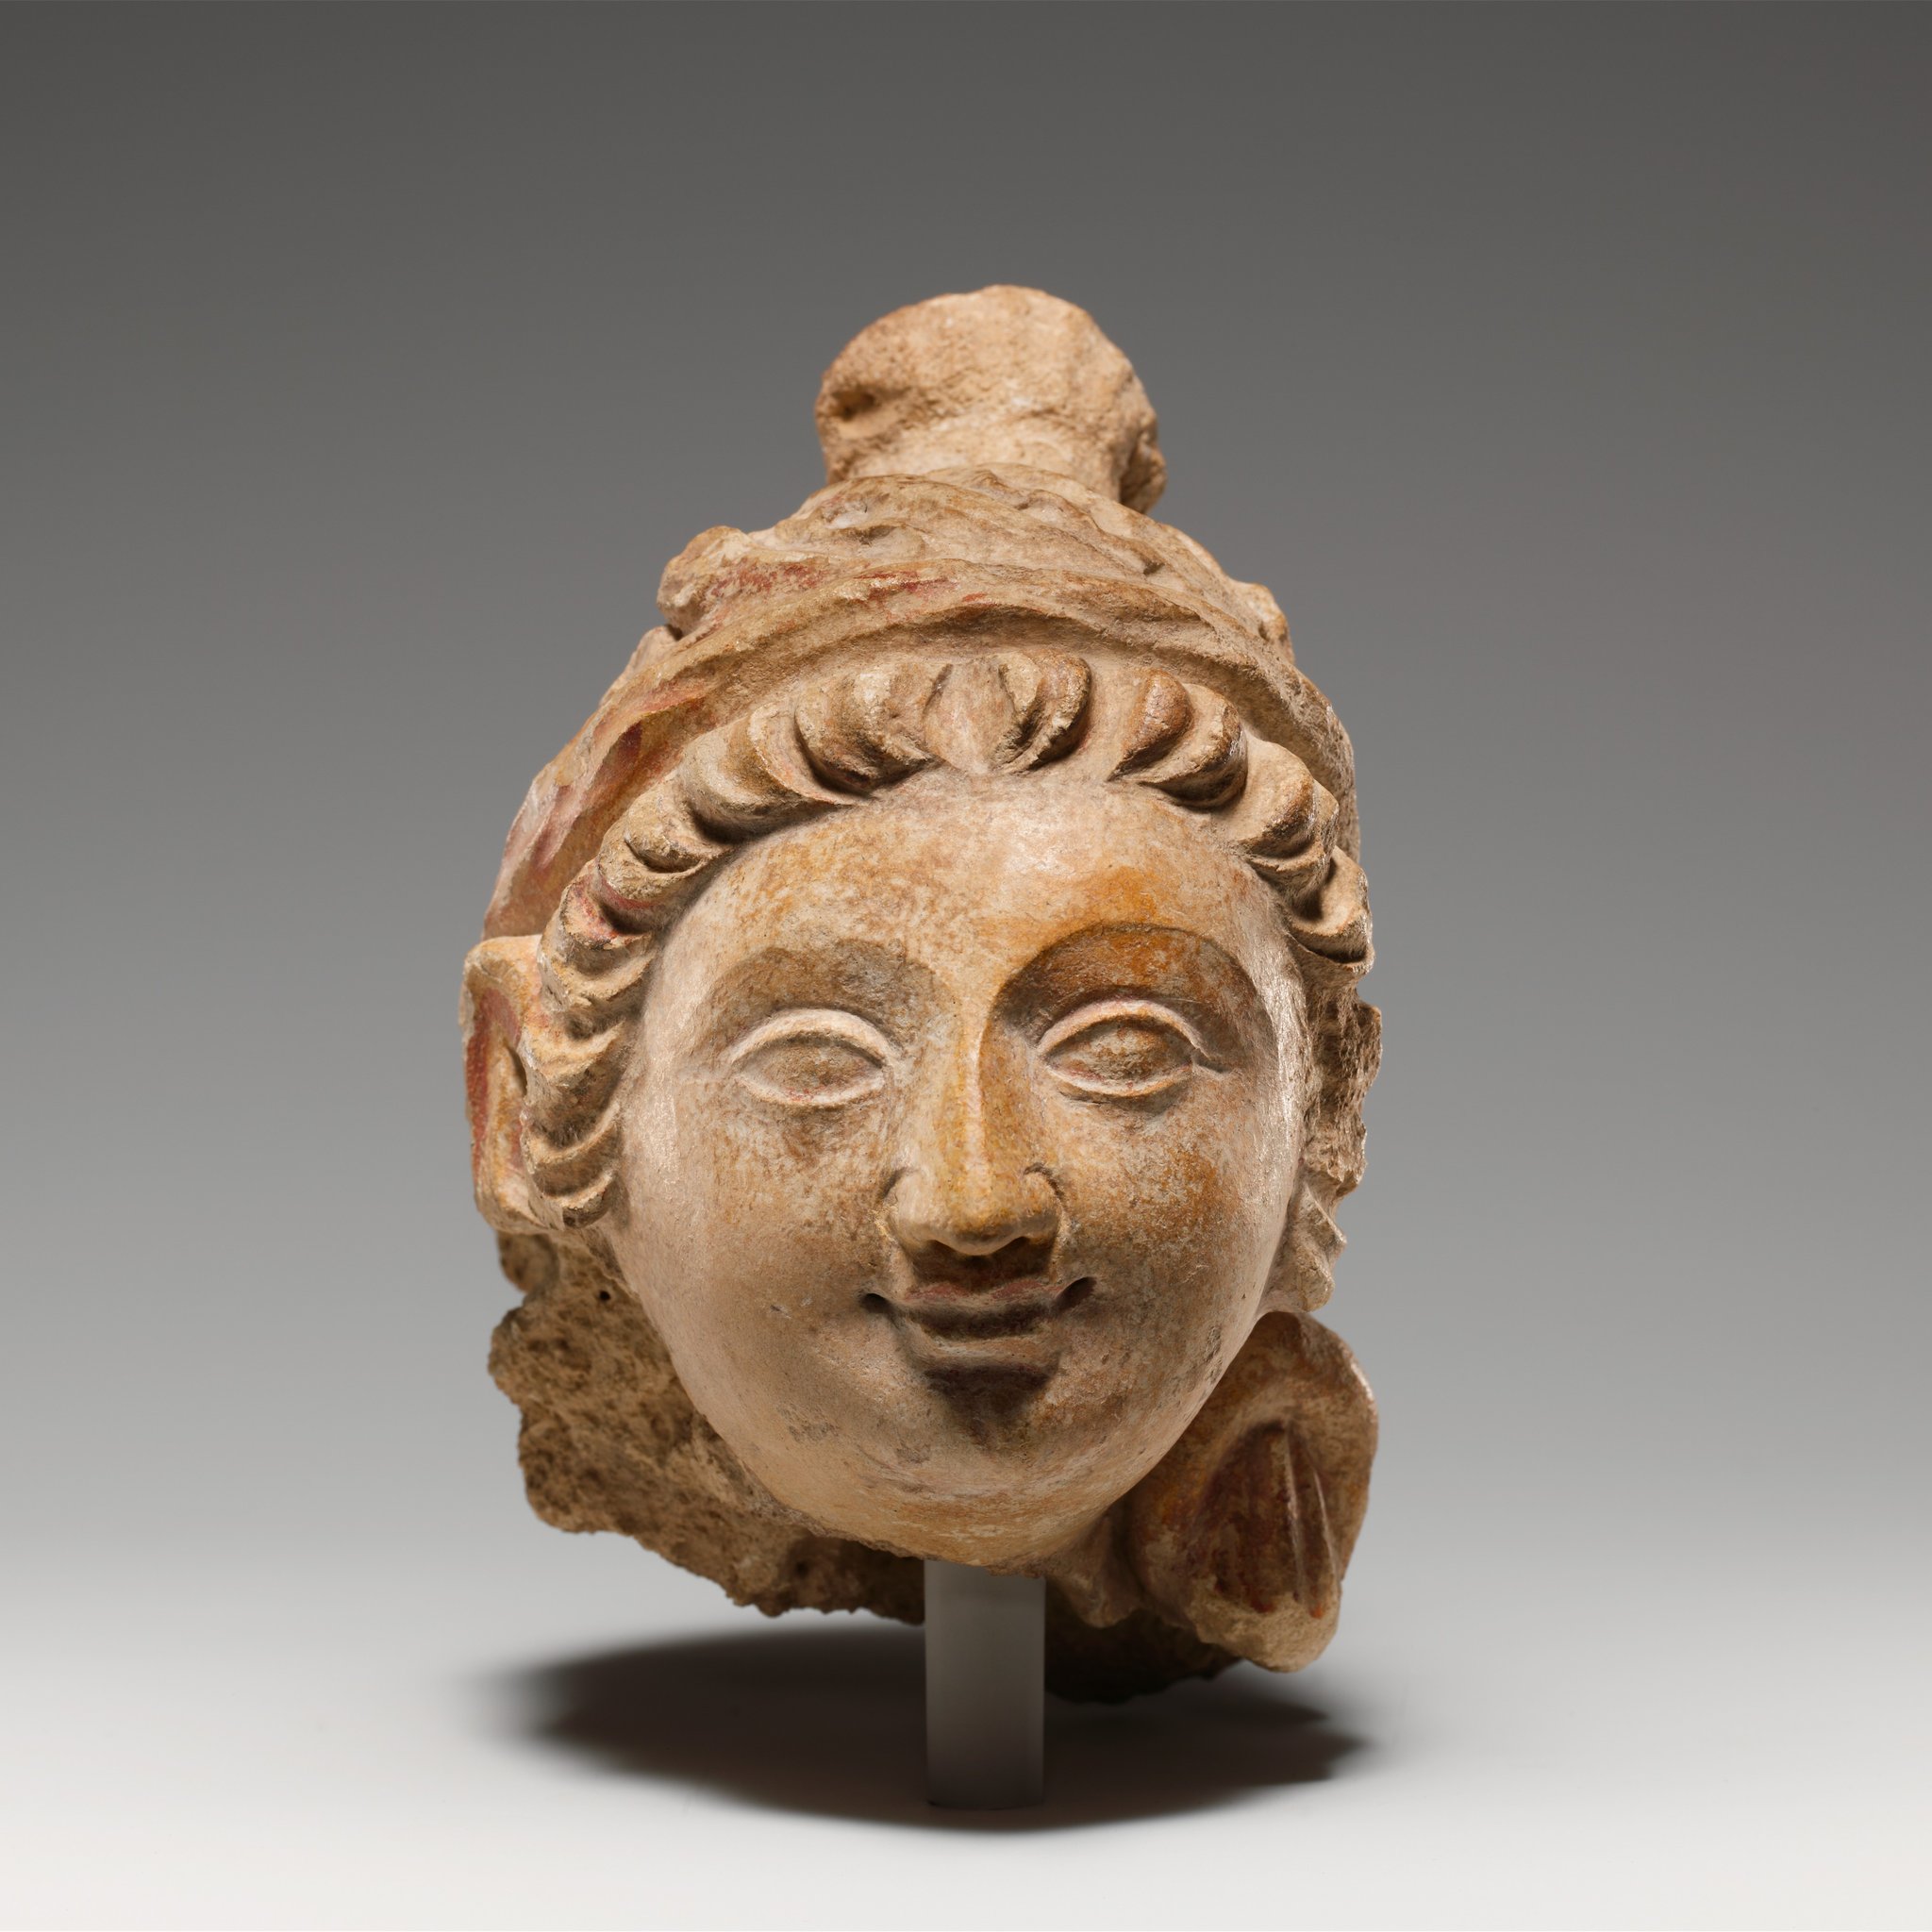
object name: head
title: Head of a Female Figure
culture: gandhara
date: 201-400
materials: plaster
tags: gandhara,heads,women